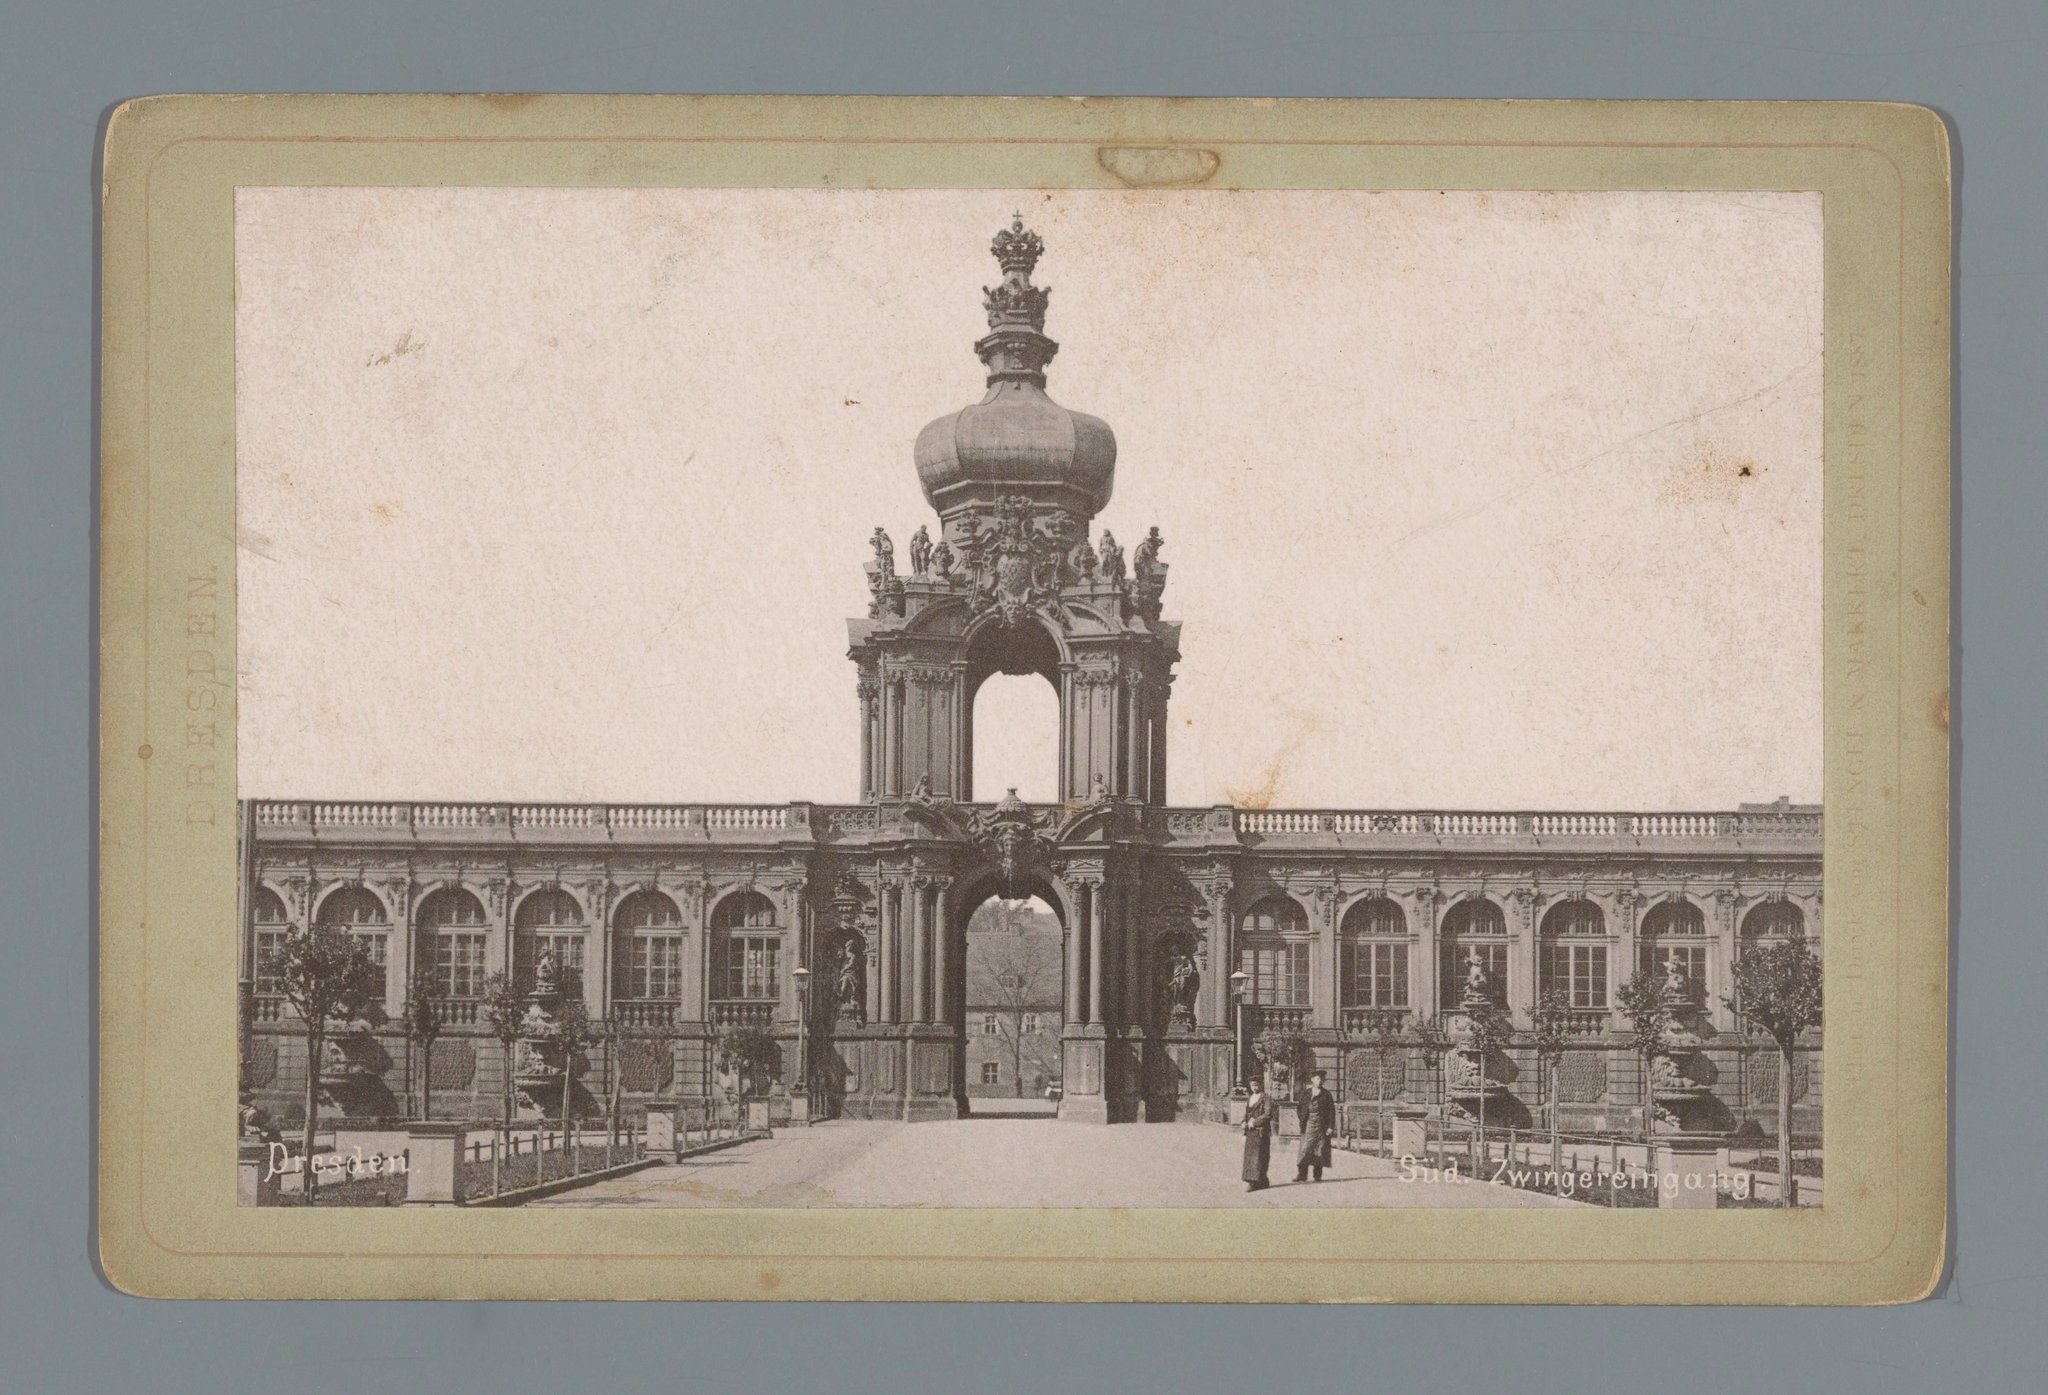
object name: photomechanical print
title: Dresden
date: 1887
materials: cardboard, paper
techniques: photograph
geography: dresden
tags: palace, gate, entrance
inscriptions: date